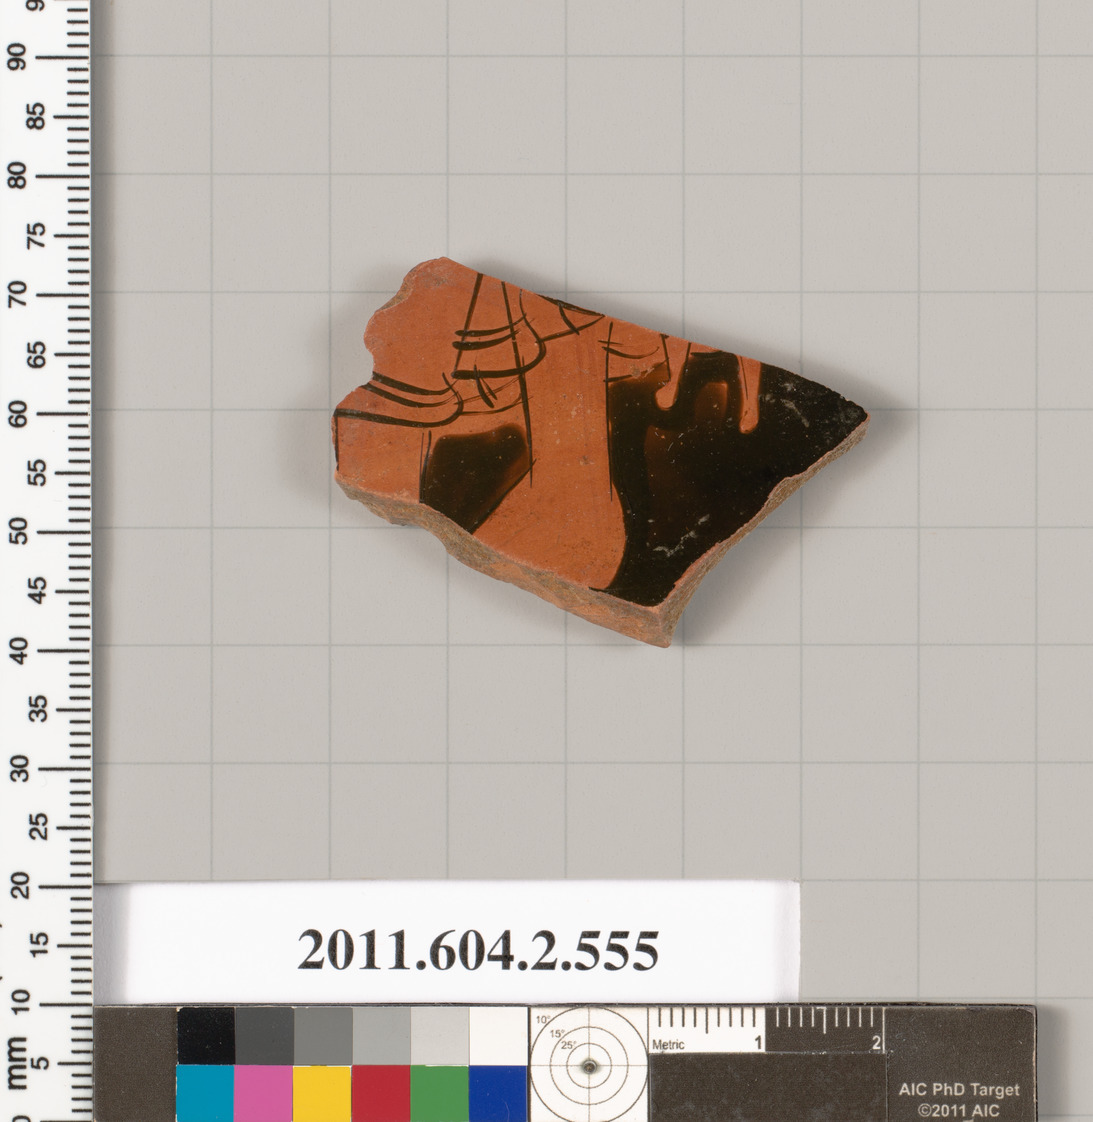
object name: column krater fragment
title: Terracotta fragment of a column-krater (bowl for mixing wine and water)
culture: greek, attic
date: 470-450 BCE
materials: terracotta